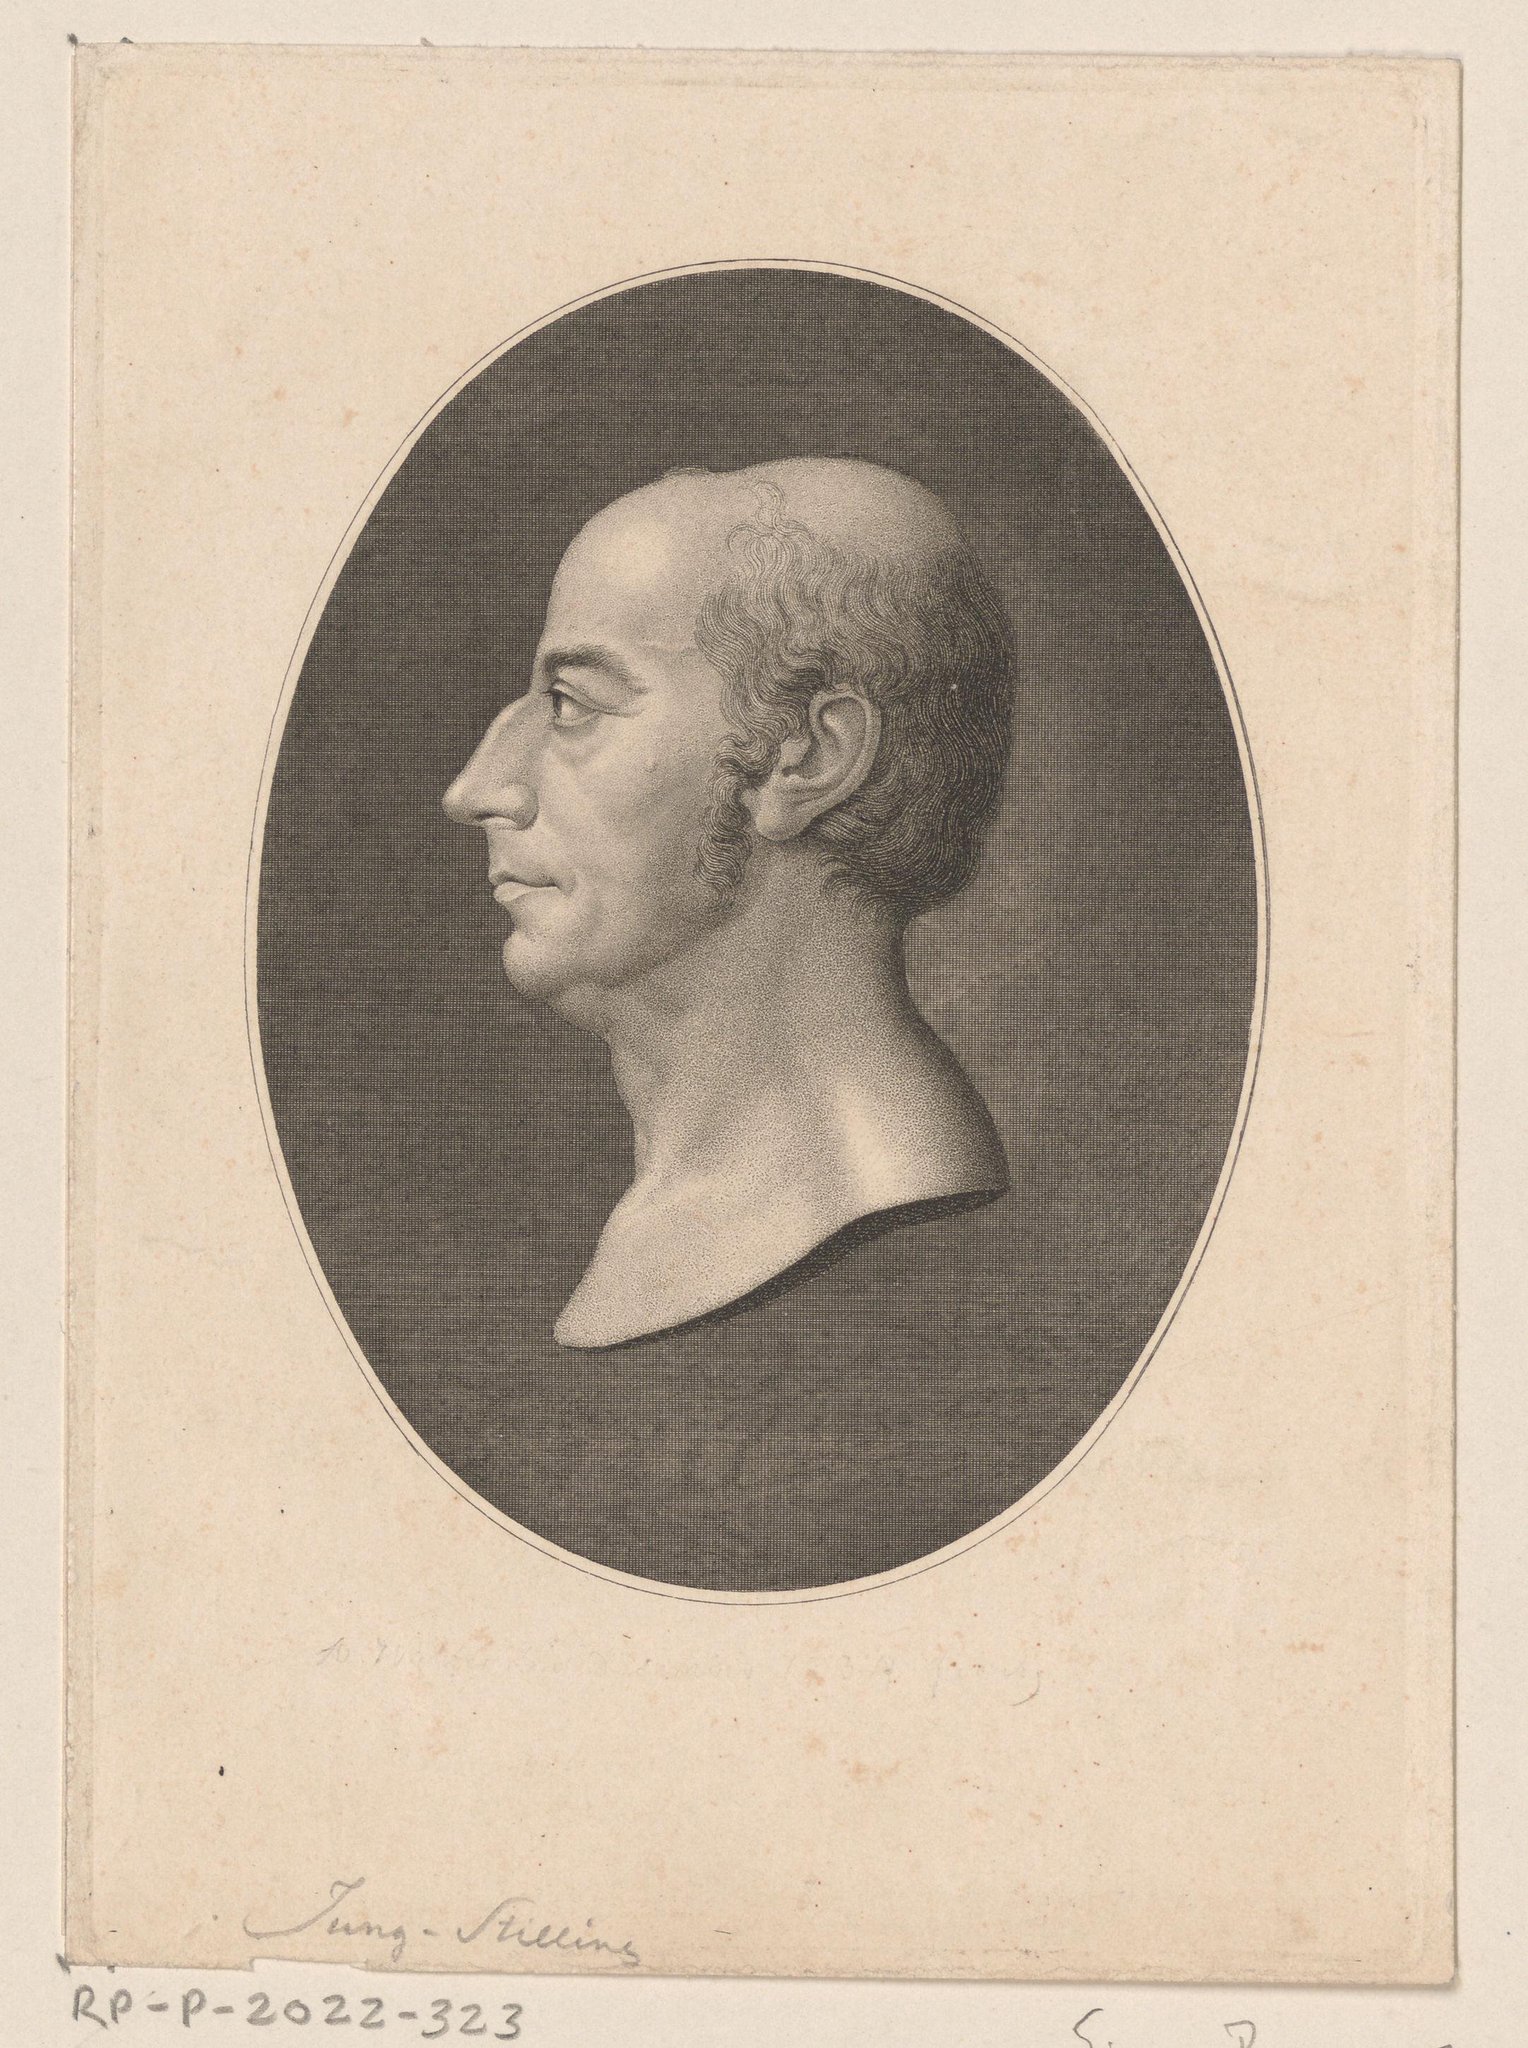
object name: print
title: Portret van Johann Heinrich Jung-Stilling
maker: carl mayer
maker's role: print maker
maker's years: 1798-1868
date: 1835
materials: paper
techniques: engraving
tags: historical persons, portrait of a writer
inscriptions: inscription: ‘10351’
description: Latere staat van prent gebruikt in: Jung-Stilling, Johann Heinrich. Johann Heinrich Jung's, genannt Stilling, sämmtliche Schriften. Stuttgart: Friedrich Henne, 1835, dl. 1.